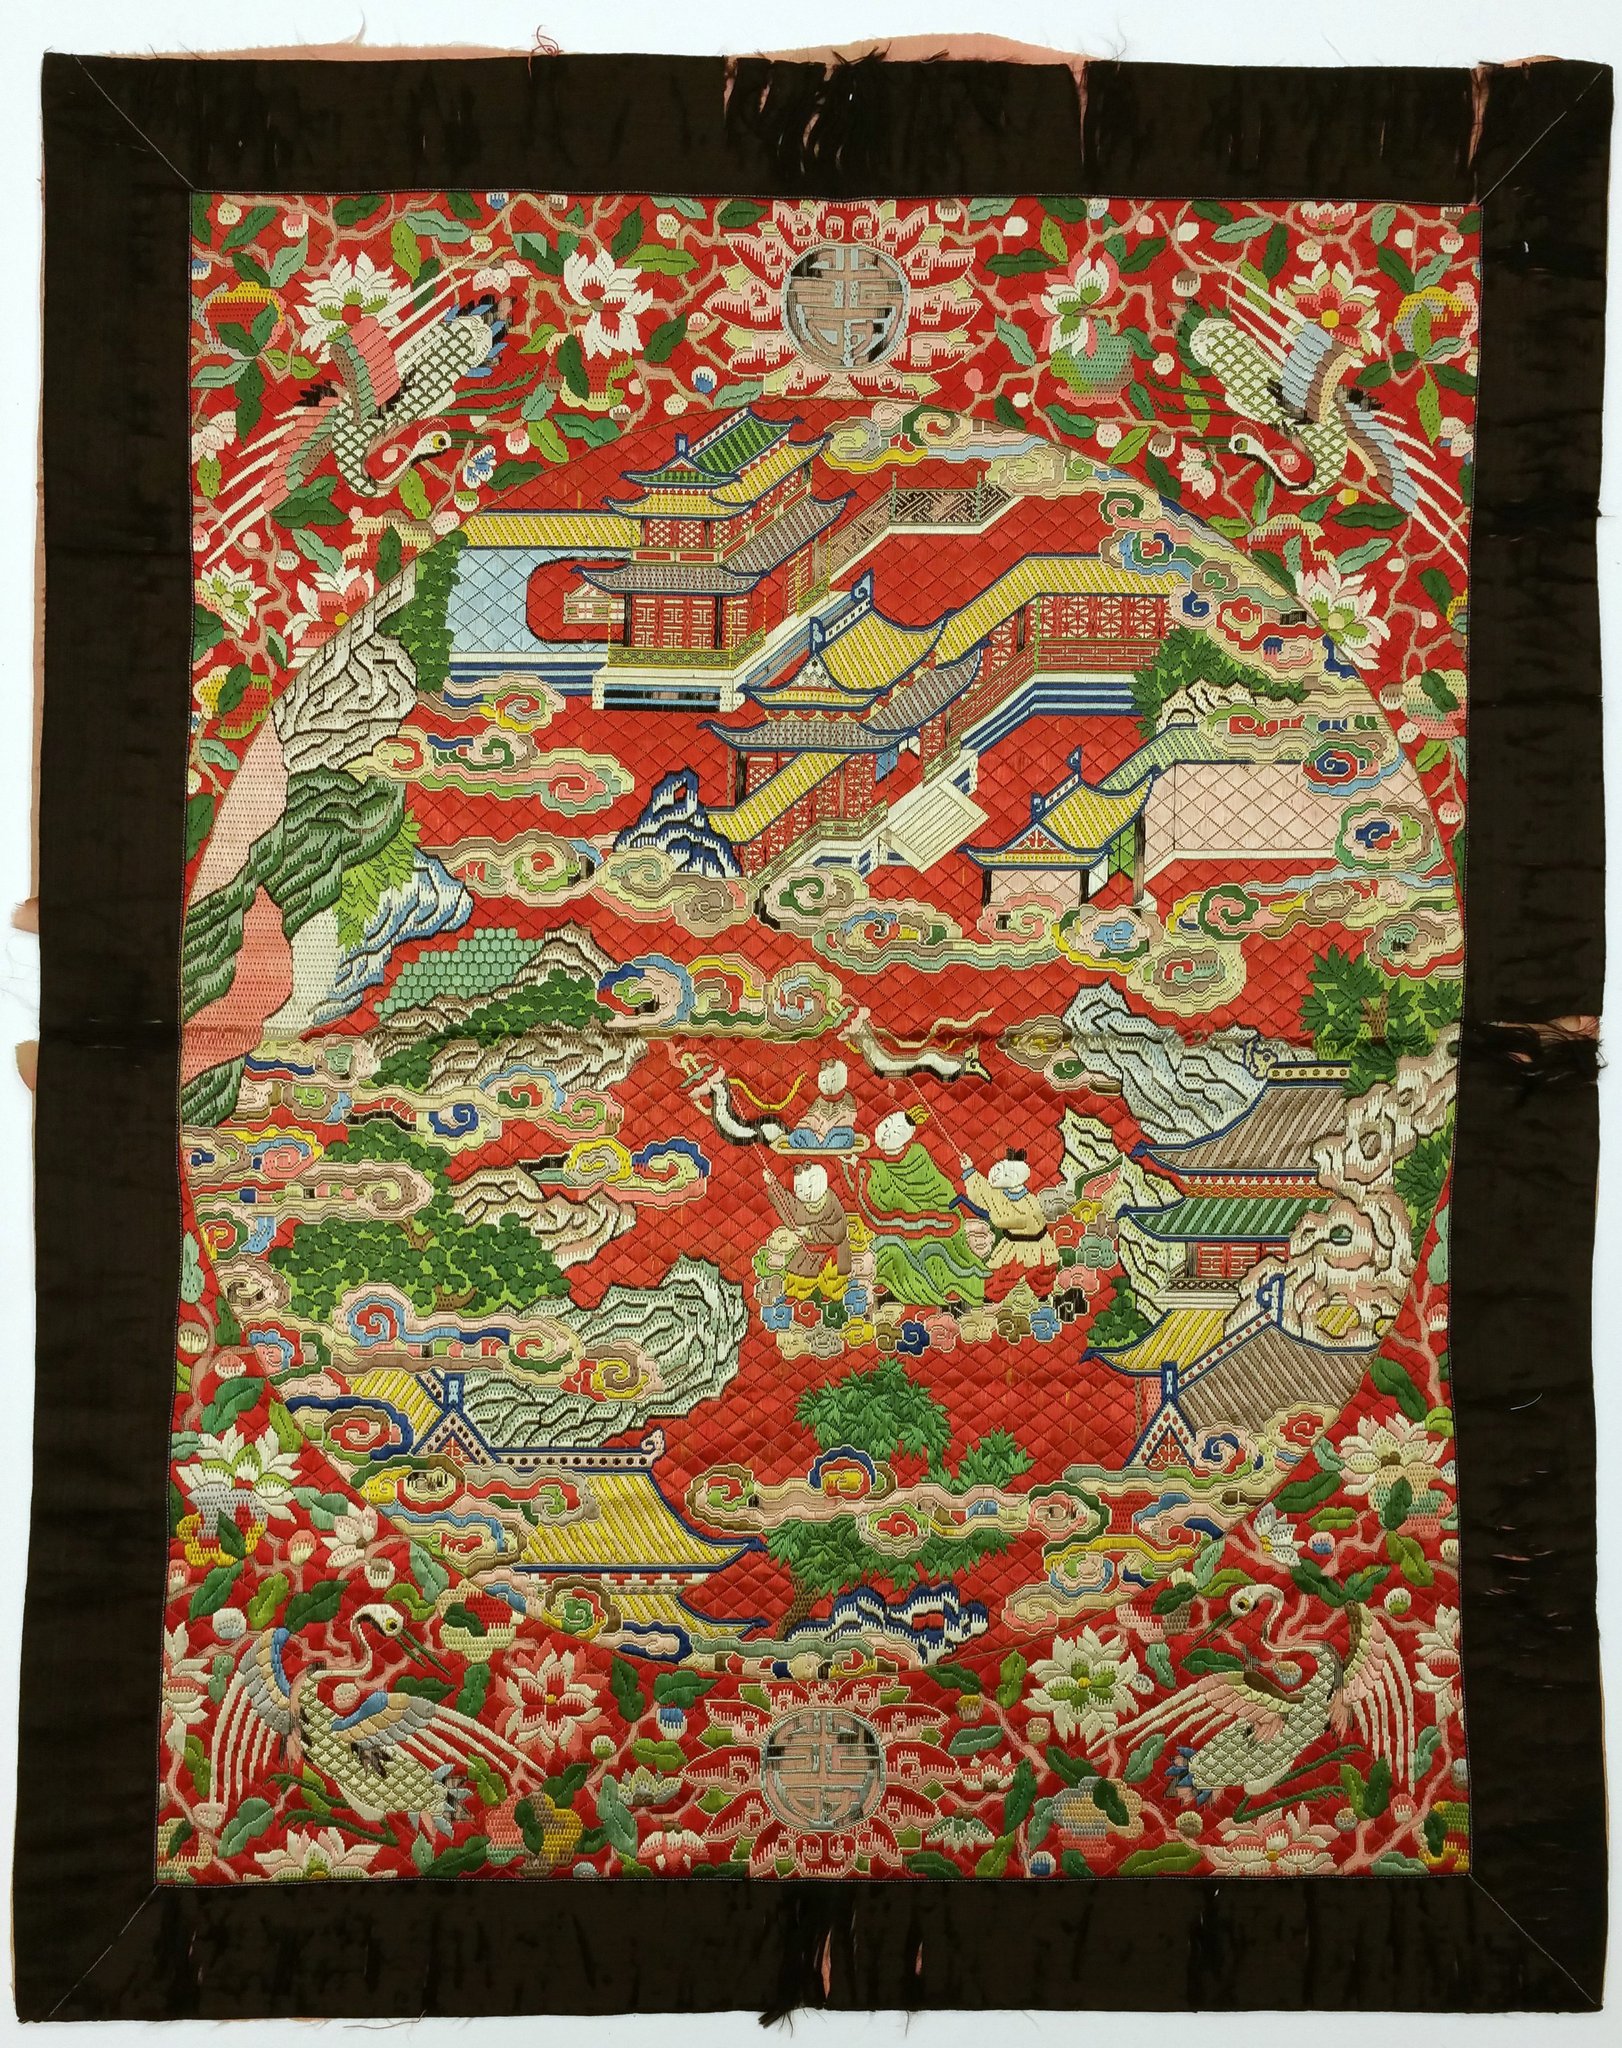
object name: panel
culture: chinese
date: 1601-1700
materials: silk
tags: human figures,birds,houses,flowers